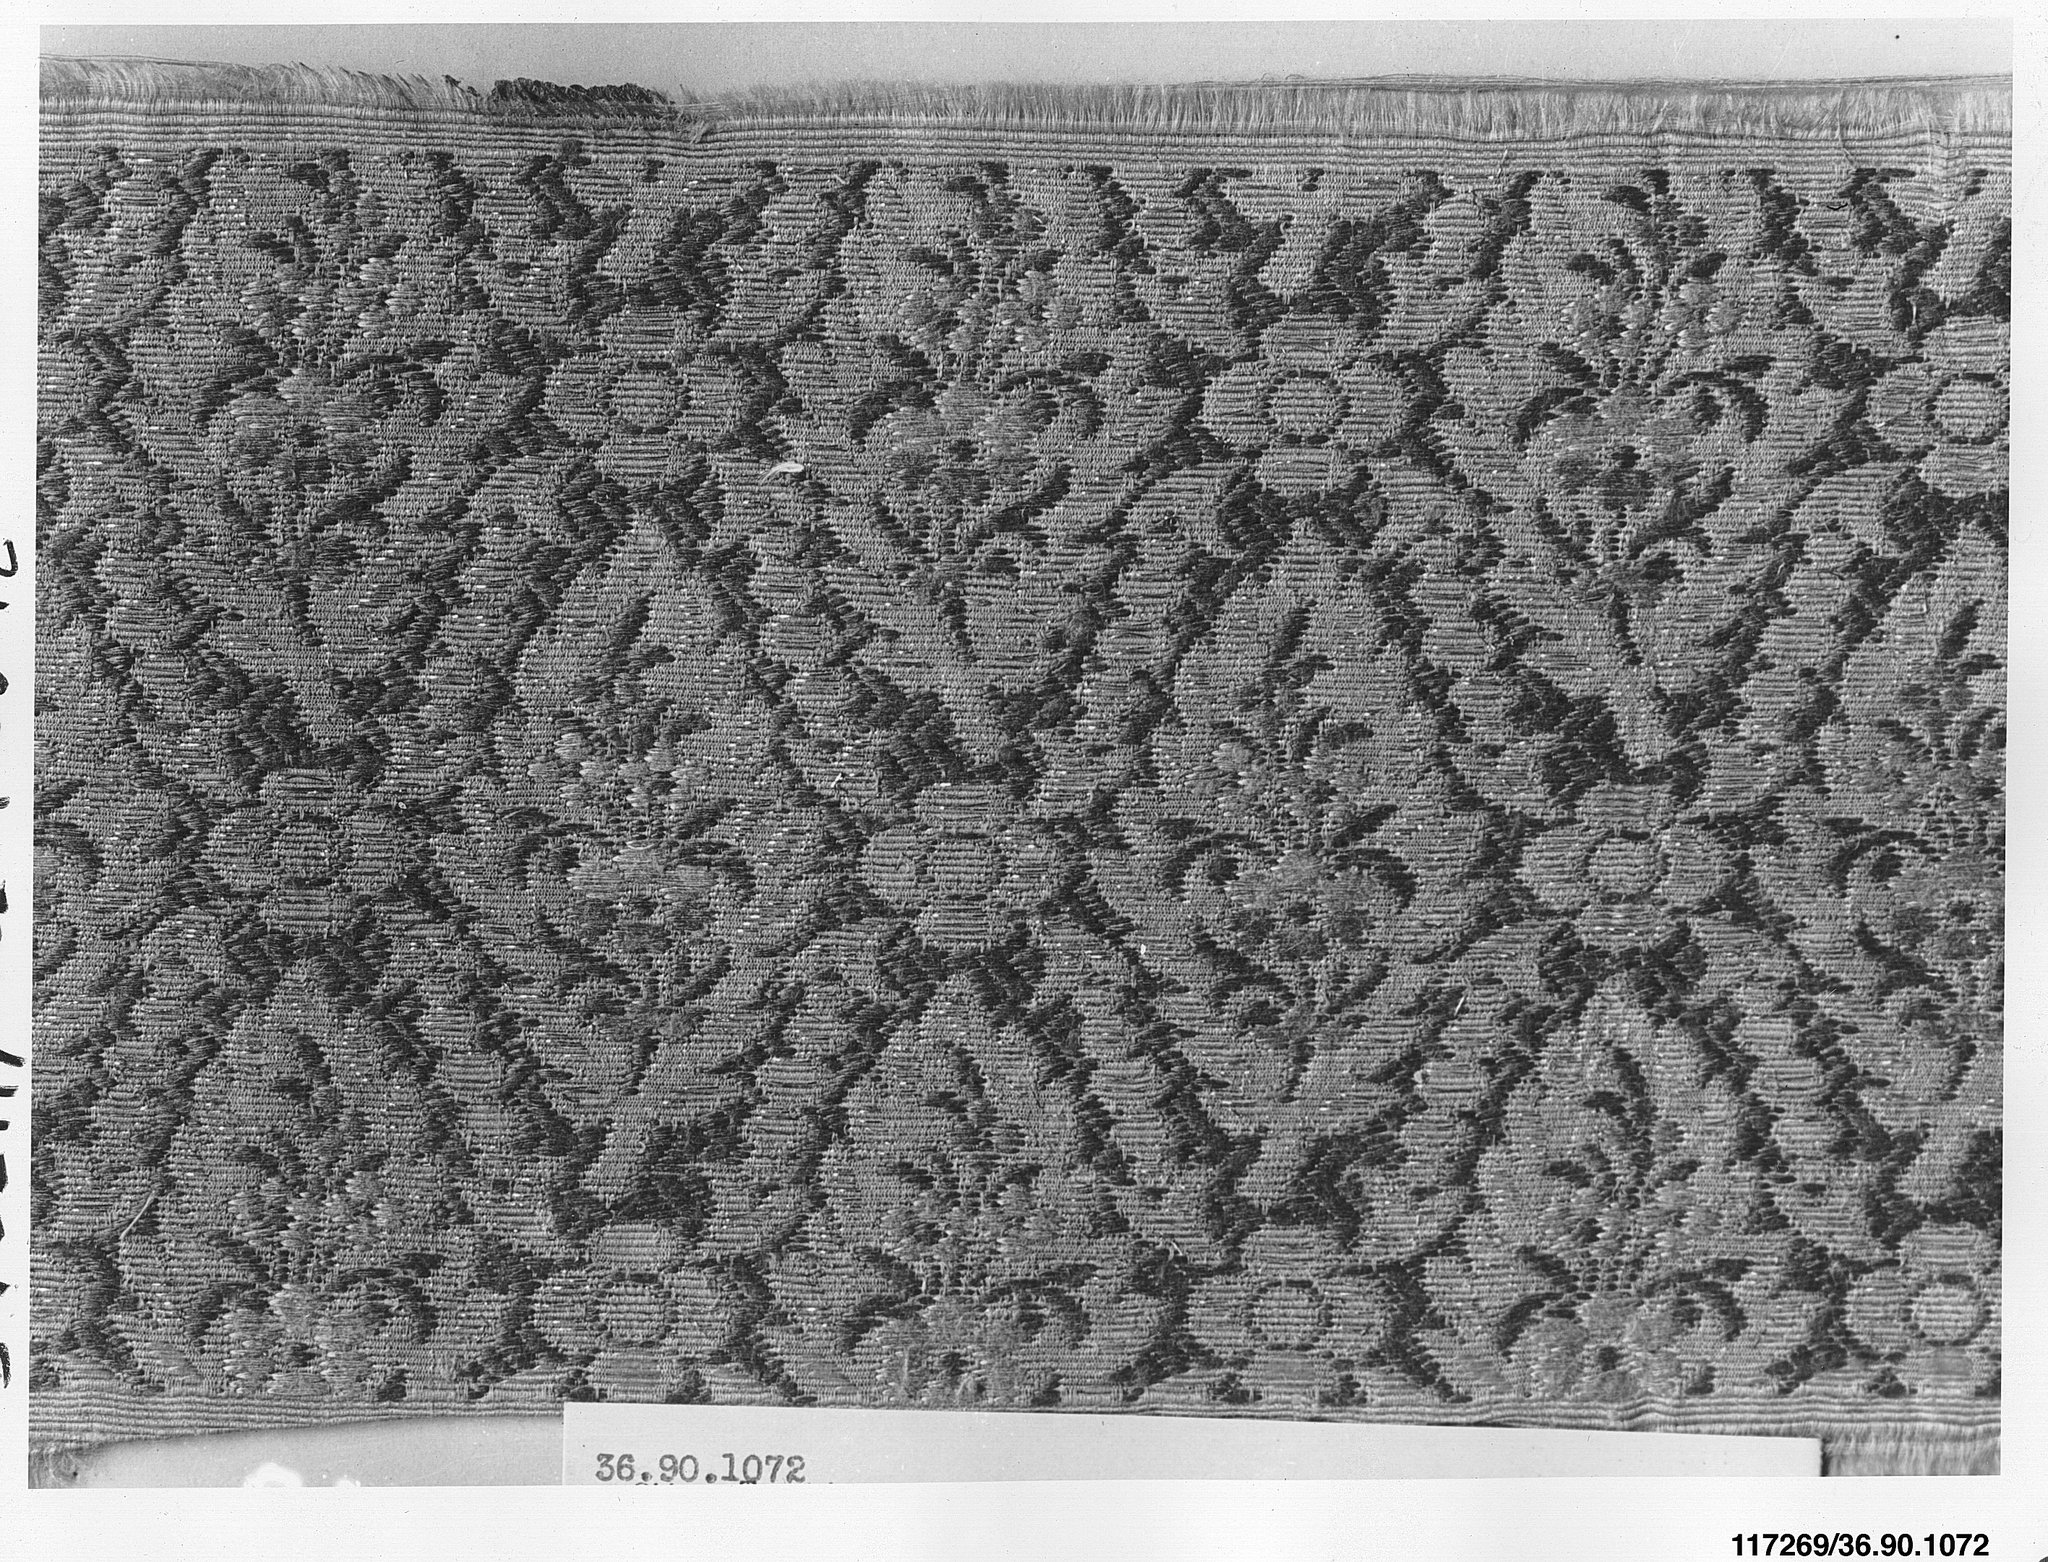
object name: piece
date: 1801-1900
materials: silk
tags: flowers,leaves